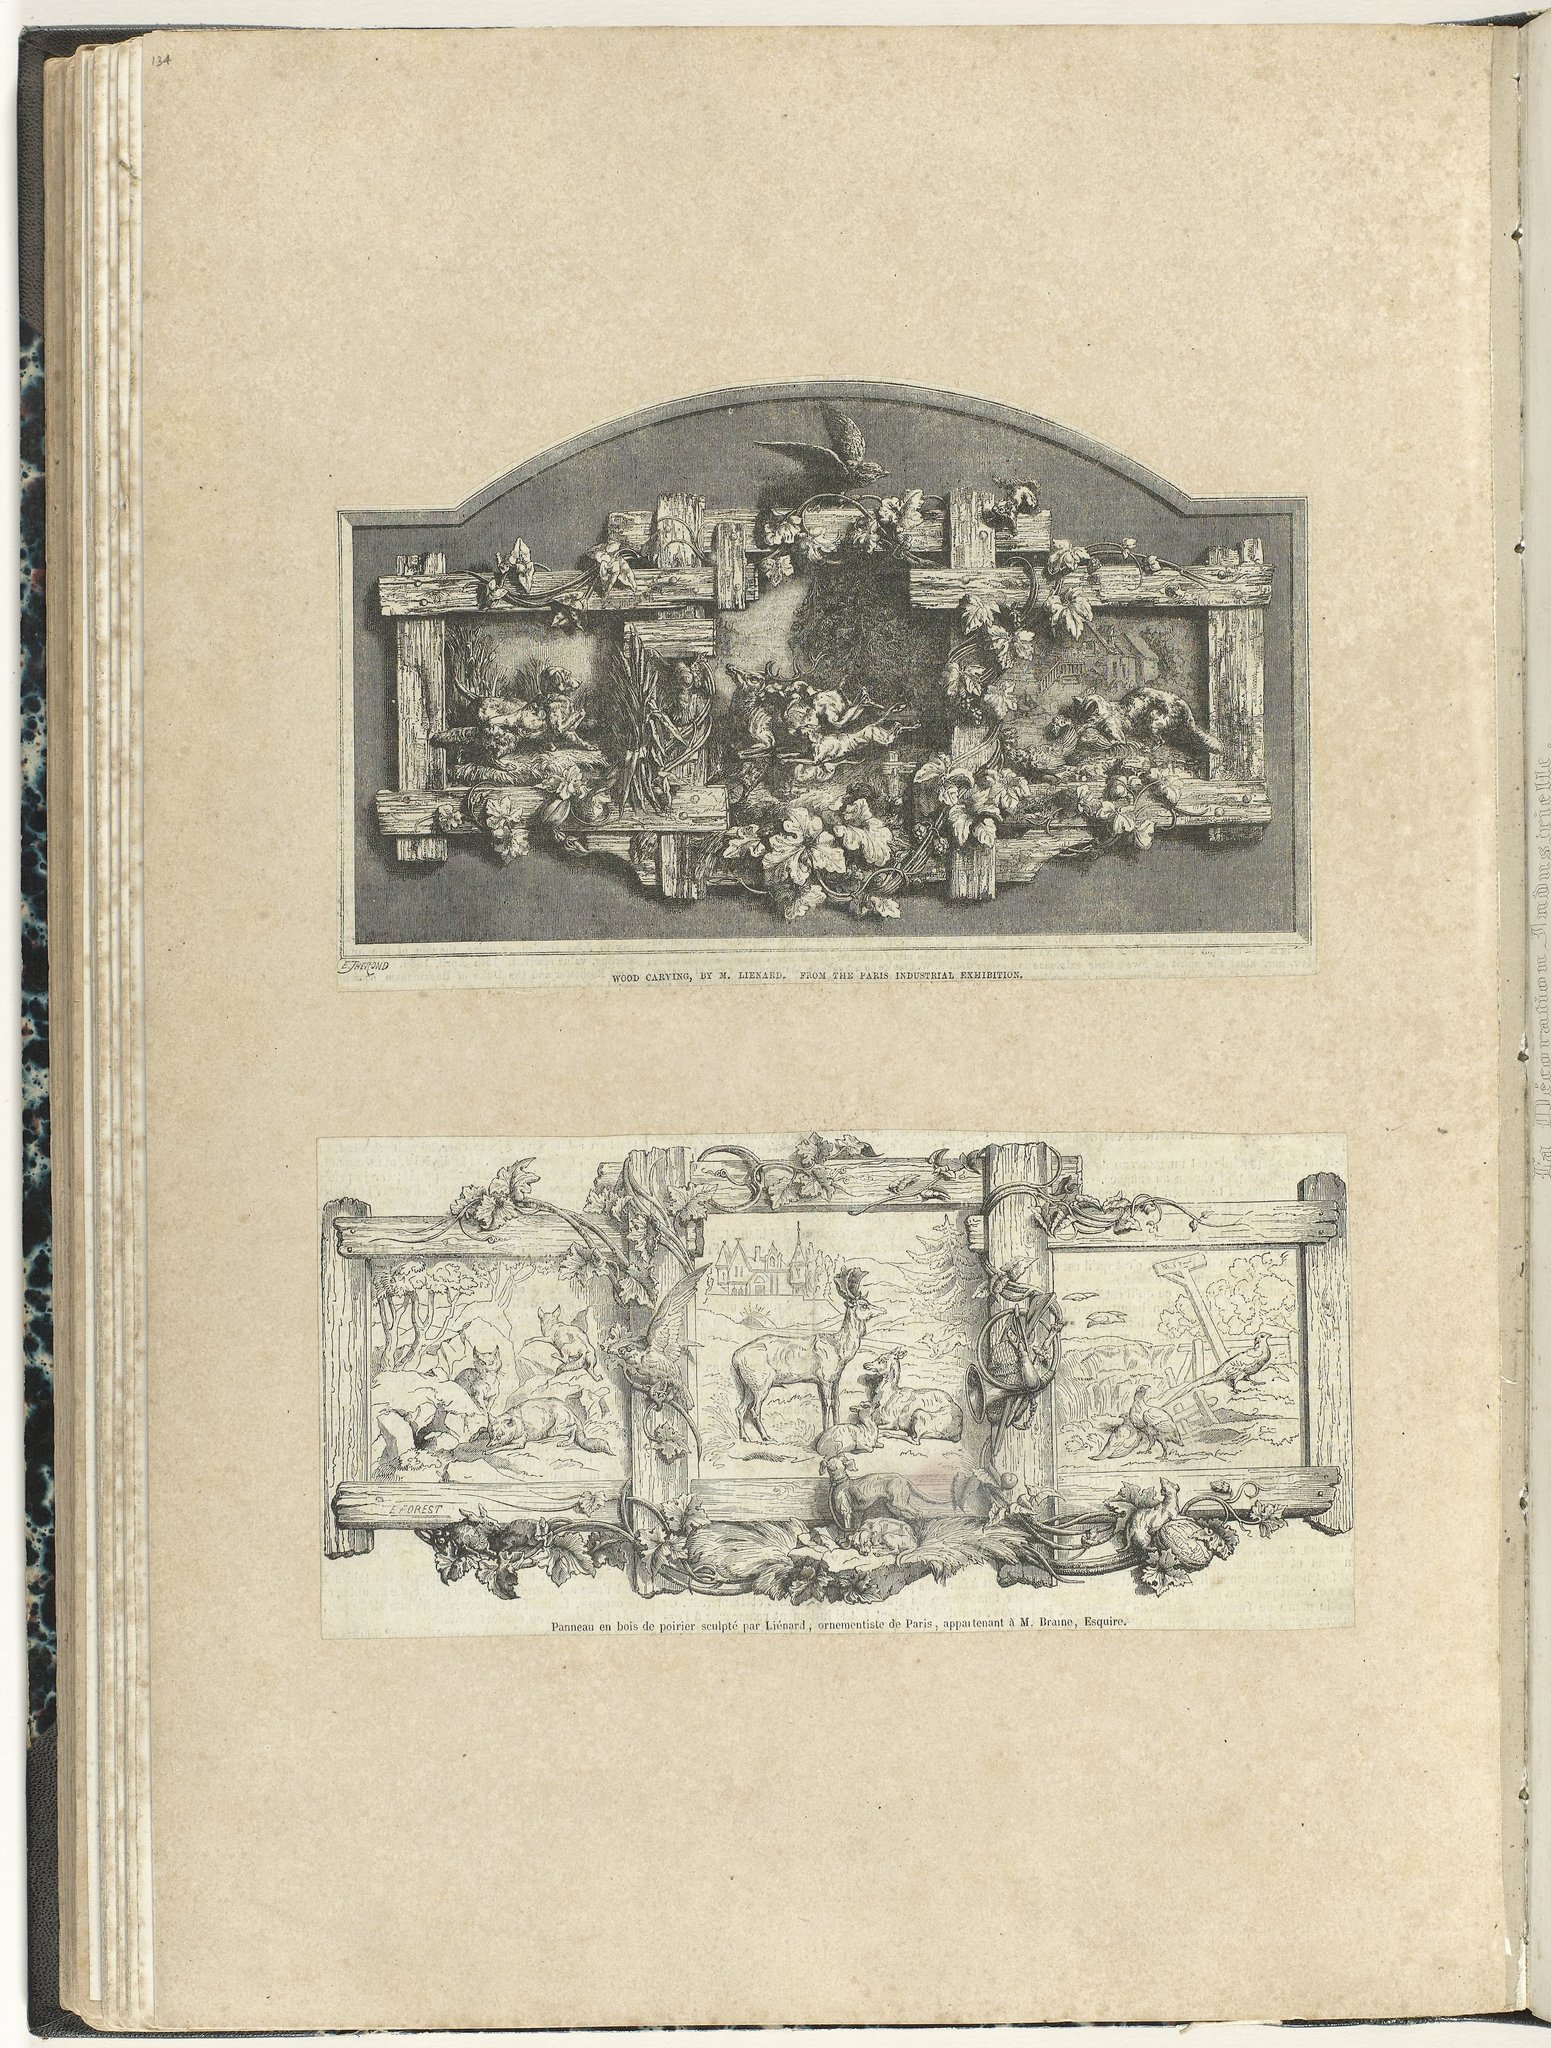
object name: newspaper clipping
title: Twee omlijstingen van houten planken met voorstellingen van dieren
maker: Anonymous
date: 1866-1900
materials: paper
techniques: printing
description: Twee krantenknipsels. Op het paneel bovenaan wordt een hert aangevallen door honden, op het paneel onderaan ligt een klein hert naast twee volwassen herten.